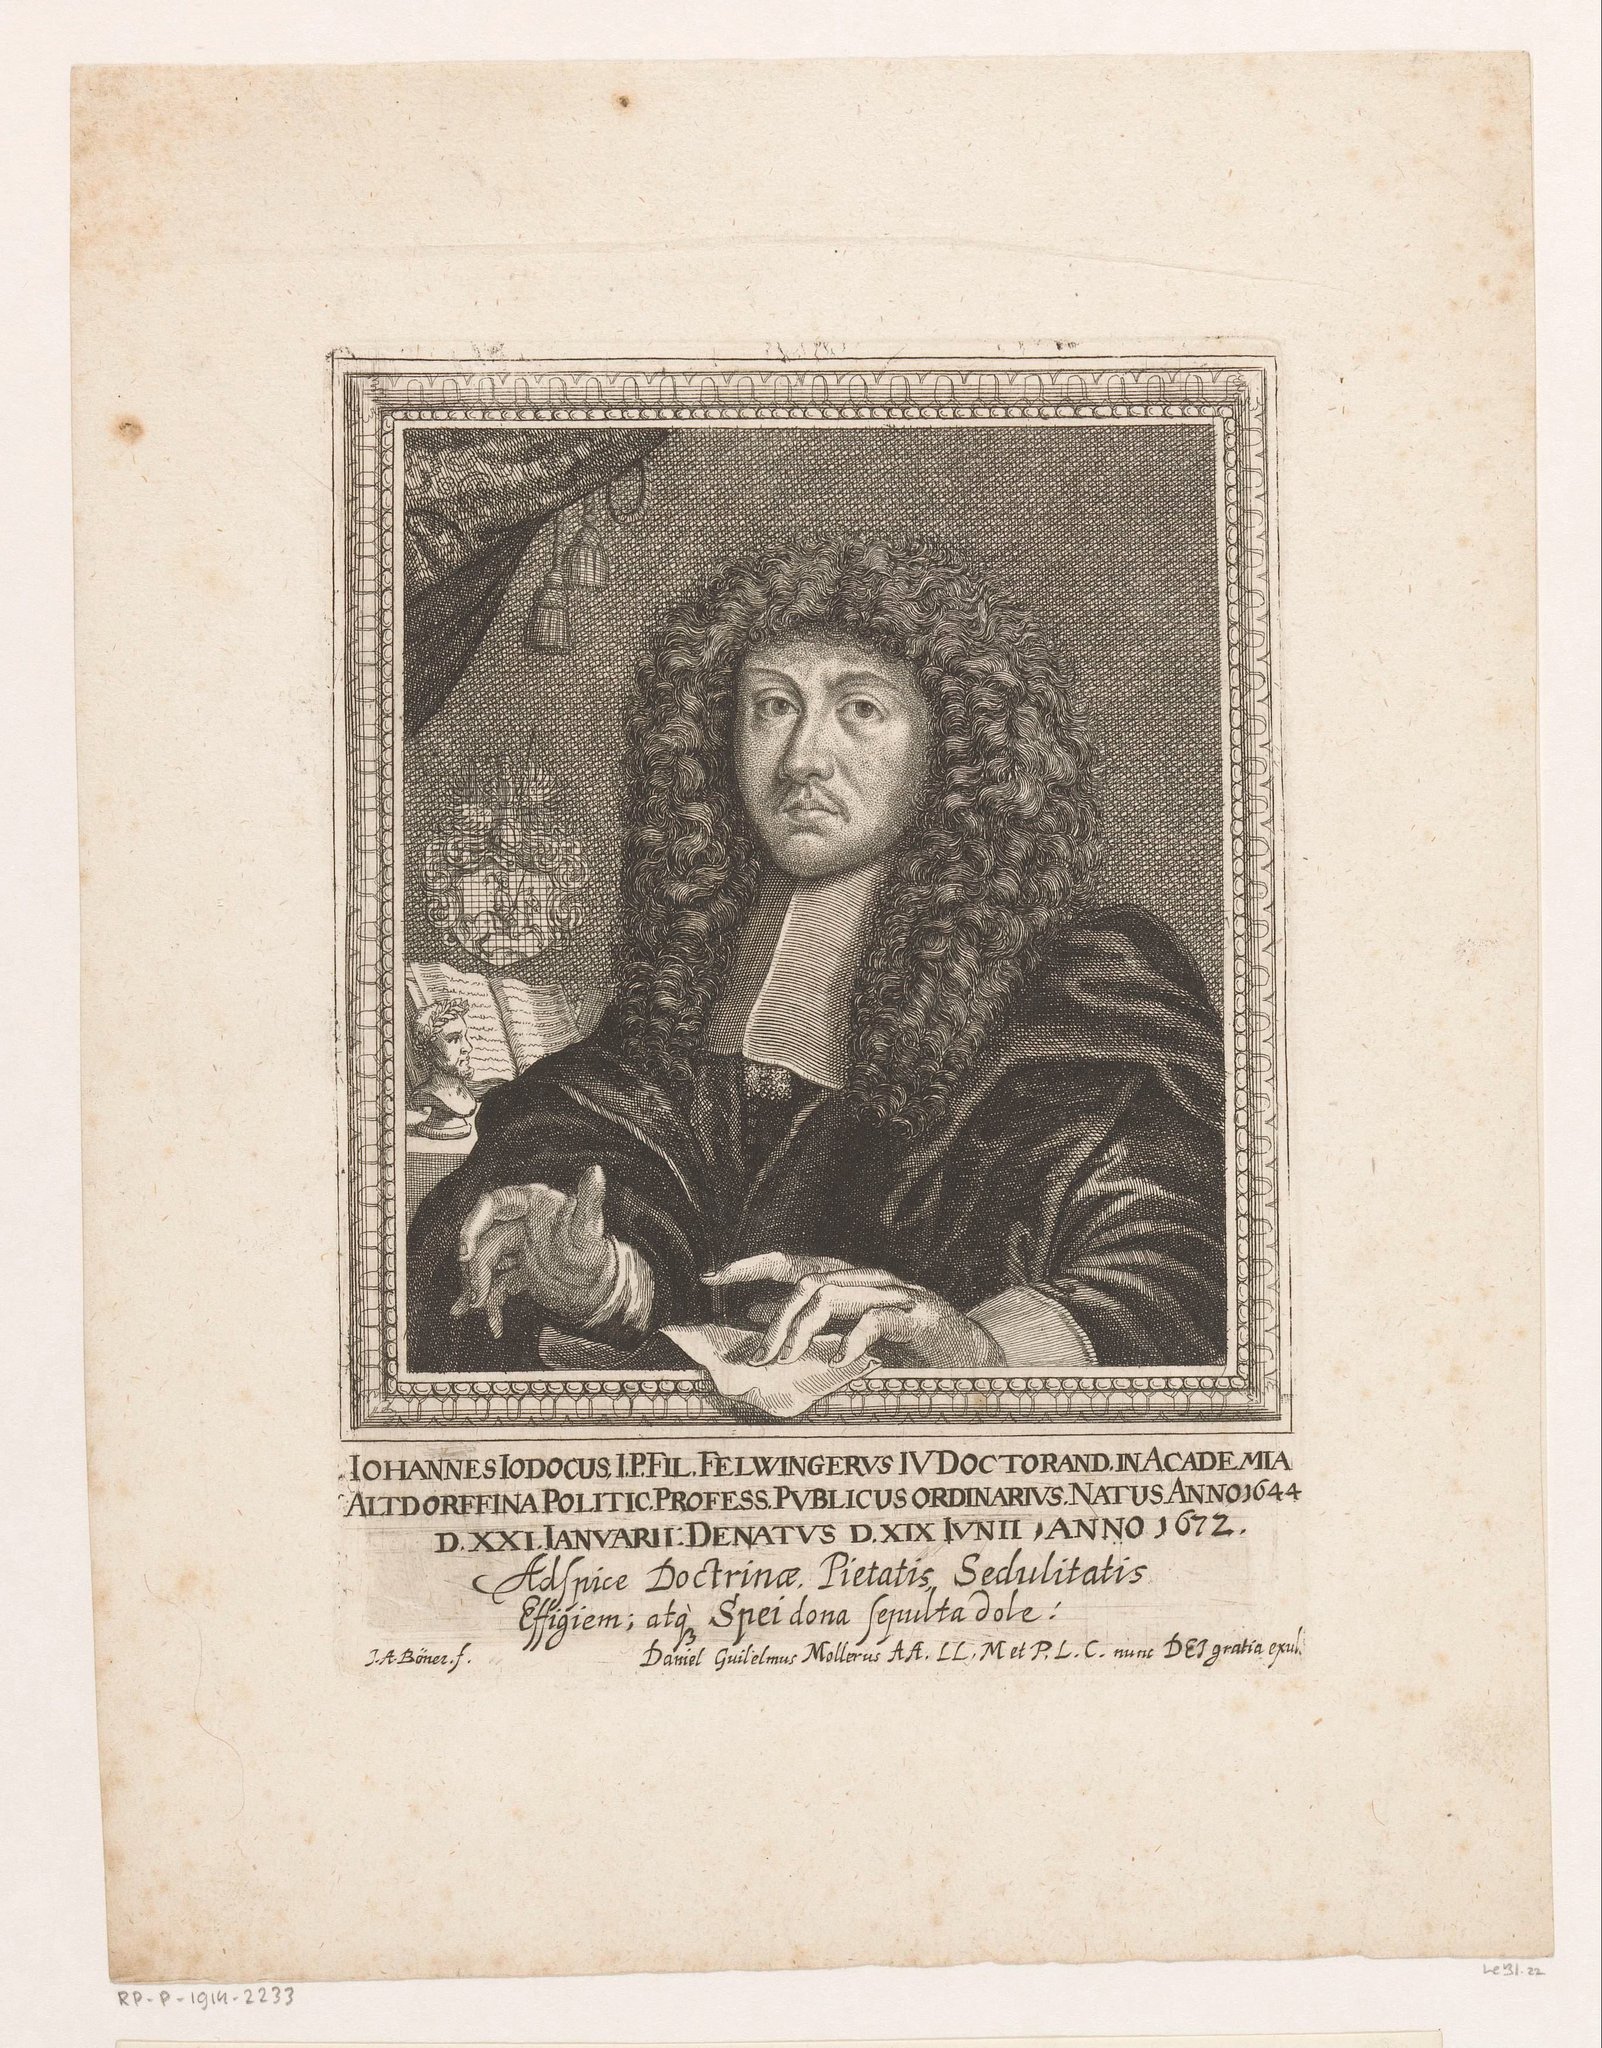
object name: print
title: Portret van Johann Jodocus Felwinger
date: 1672-1720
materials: paper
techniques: etching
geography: altdorf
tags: historical persons, book - mm - book open, paper (writing material), armorial bearing, heraldry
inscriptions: collector's mark: Lugt 2228